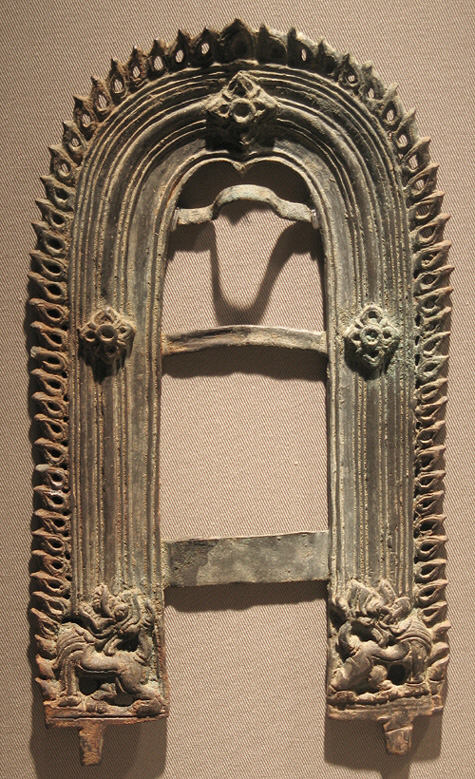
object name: halo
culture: thai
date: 1001-1100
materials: bronze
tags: animals